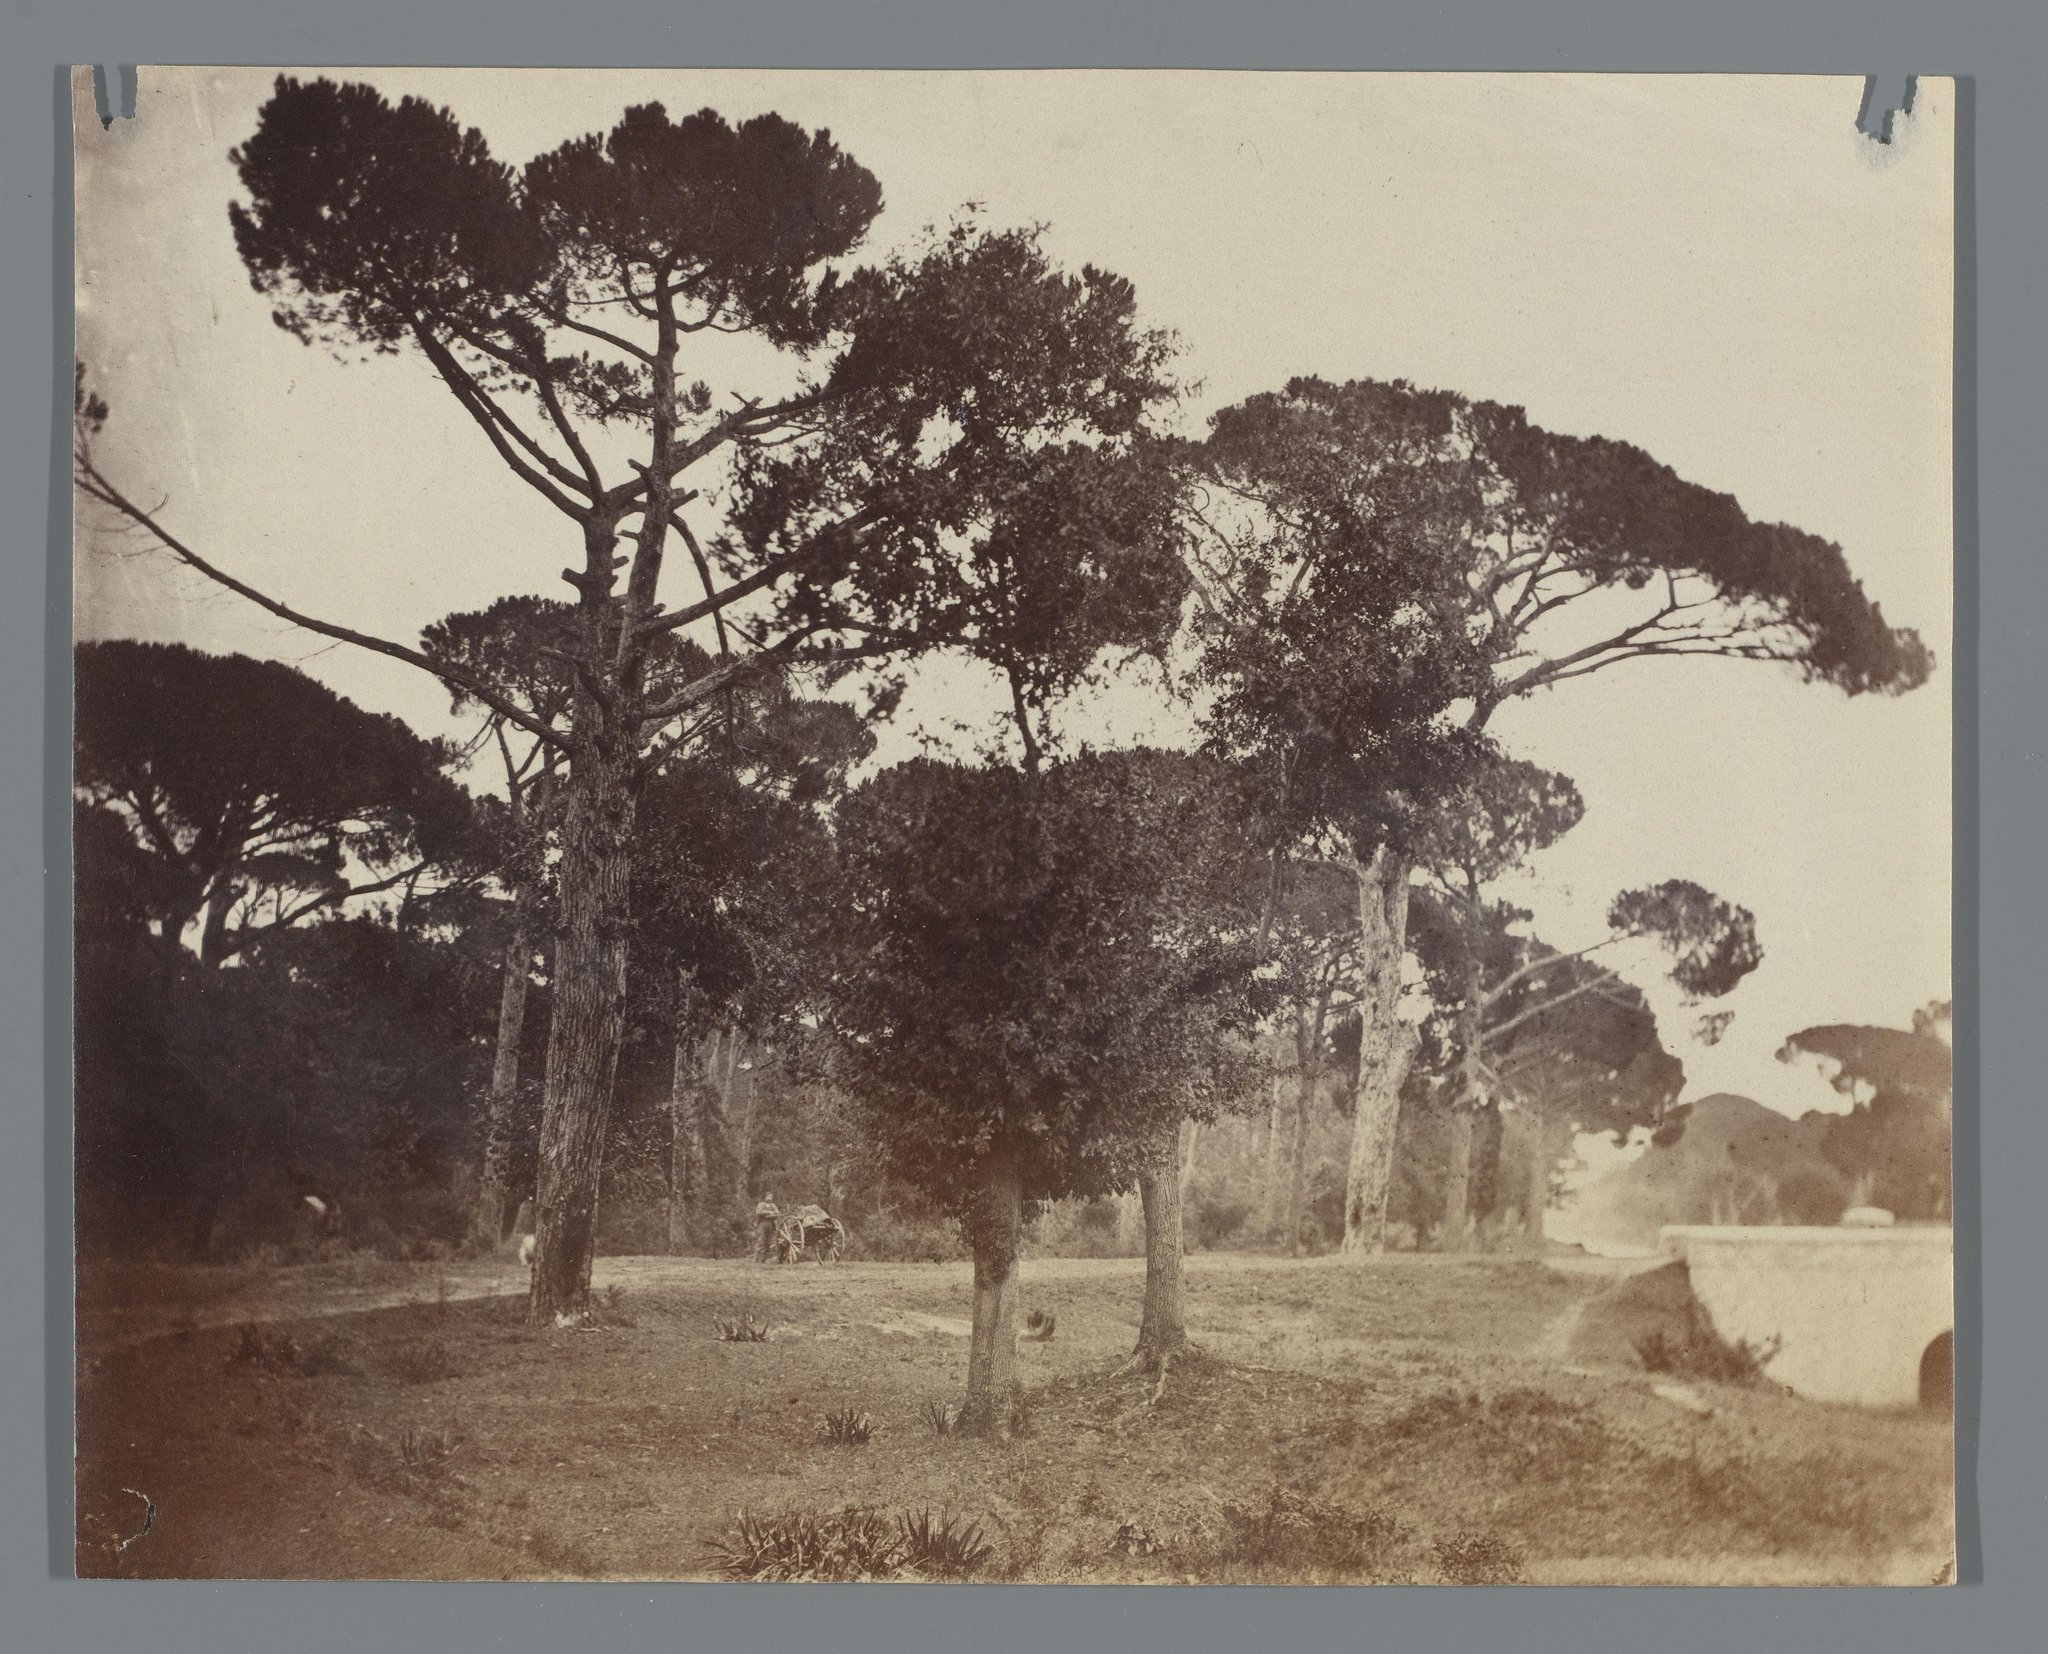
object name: photograph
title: Man met kar in landschap met bomen, vermoedelijk in Italië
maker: Anonymous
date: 1860-1900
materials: photographic support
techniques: albumen print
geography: italy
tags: hand-cart, trees, italy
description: Onderdeel van Reisalbum met opnames van kunstwerken en bezienswaardigheden in Italië, Griekenland en Frankrijk.